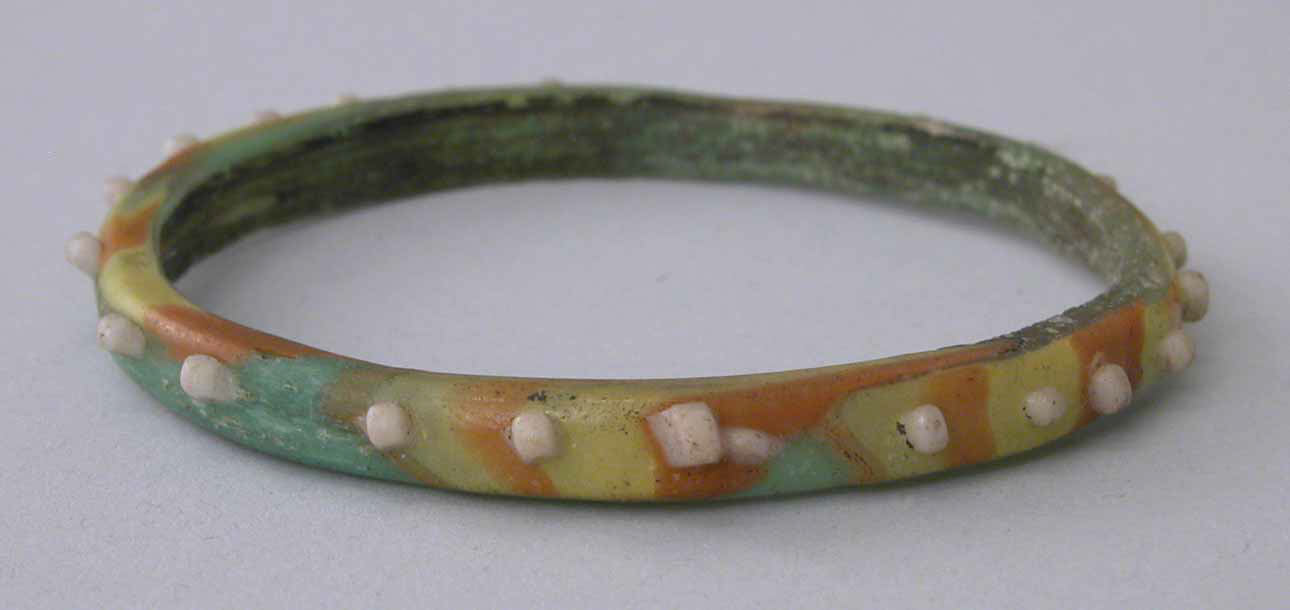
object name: bracelet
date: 1301-1500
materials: glass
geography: egypt or syria